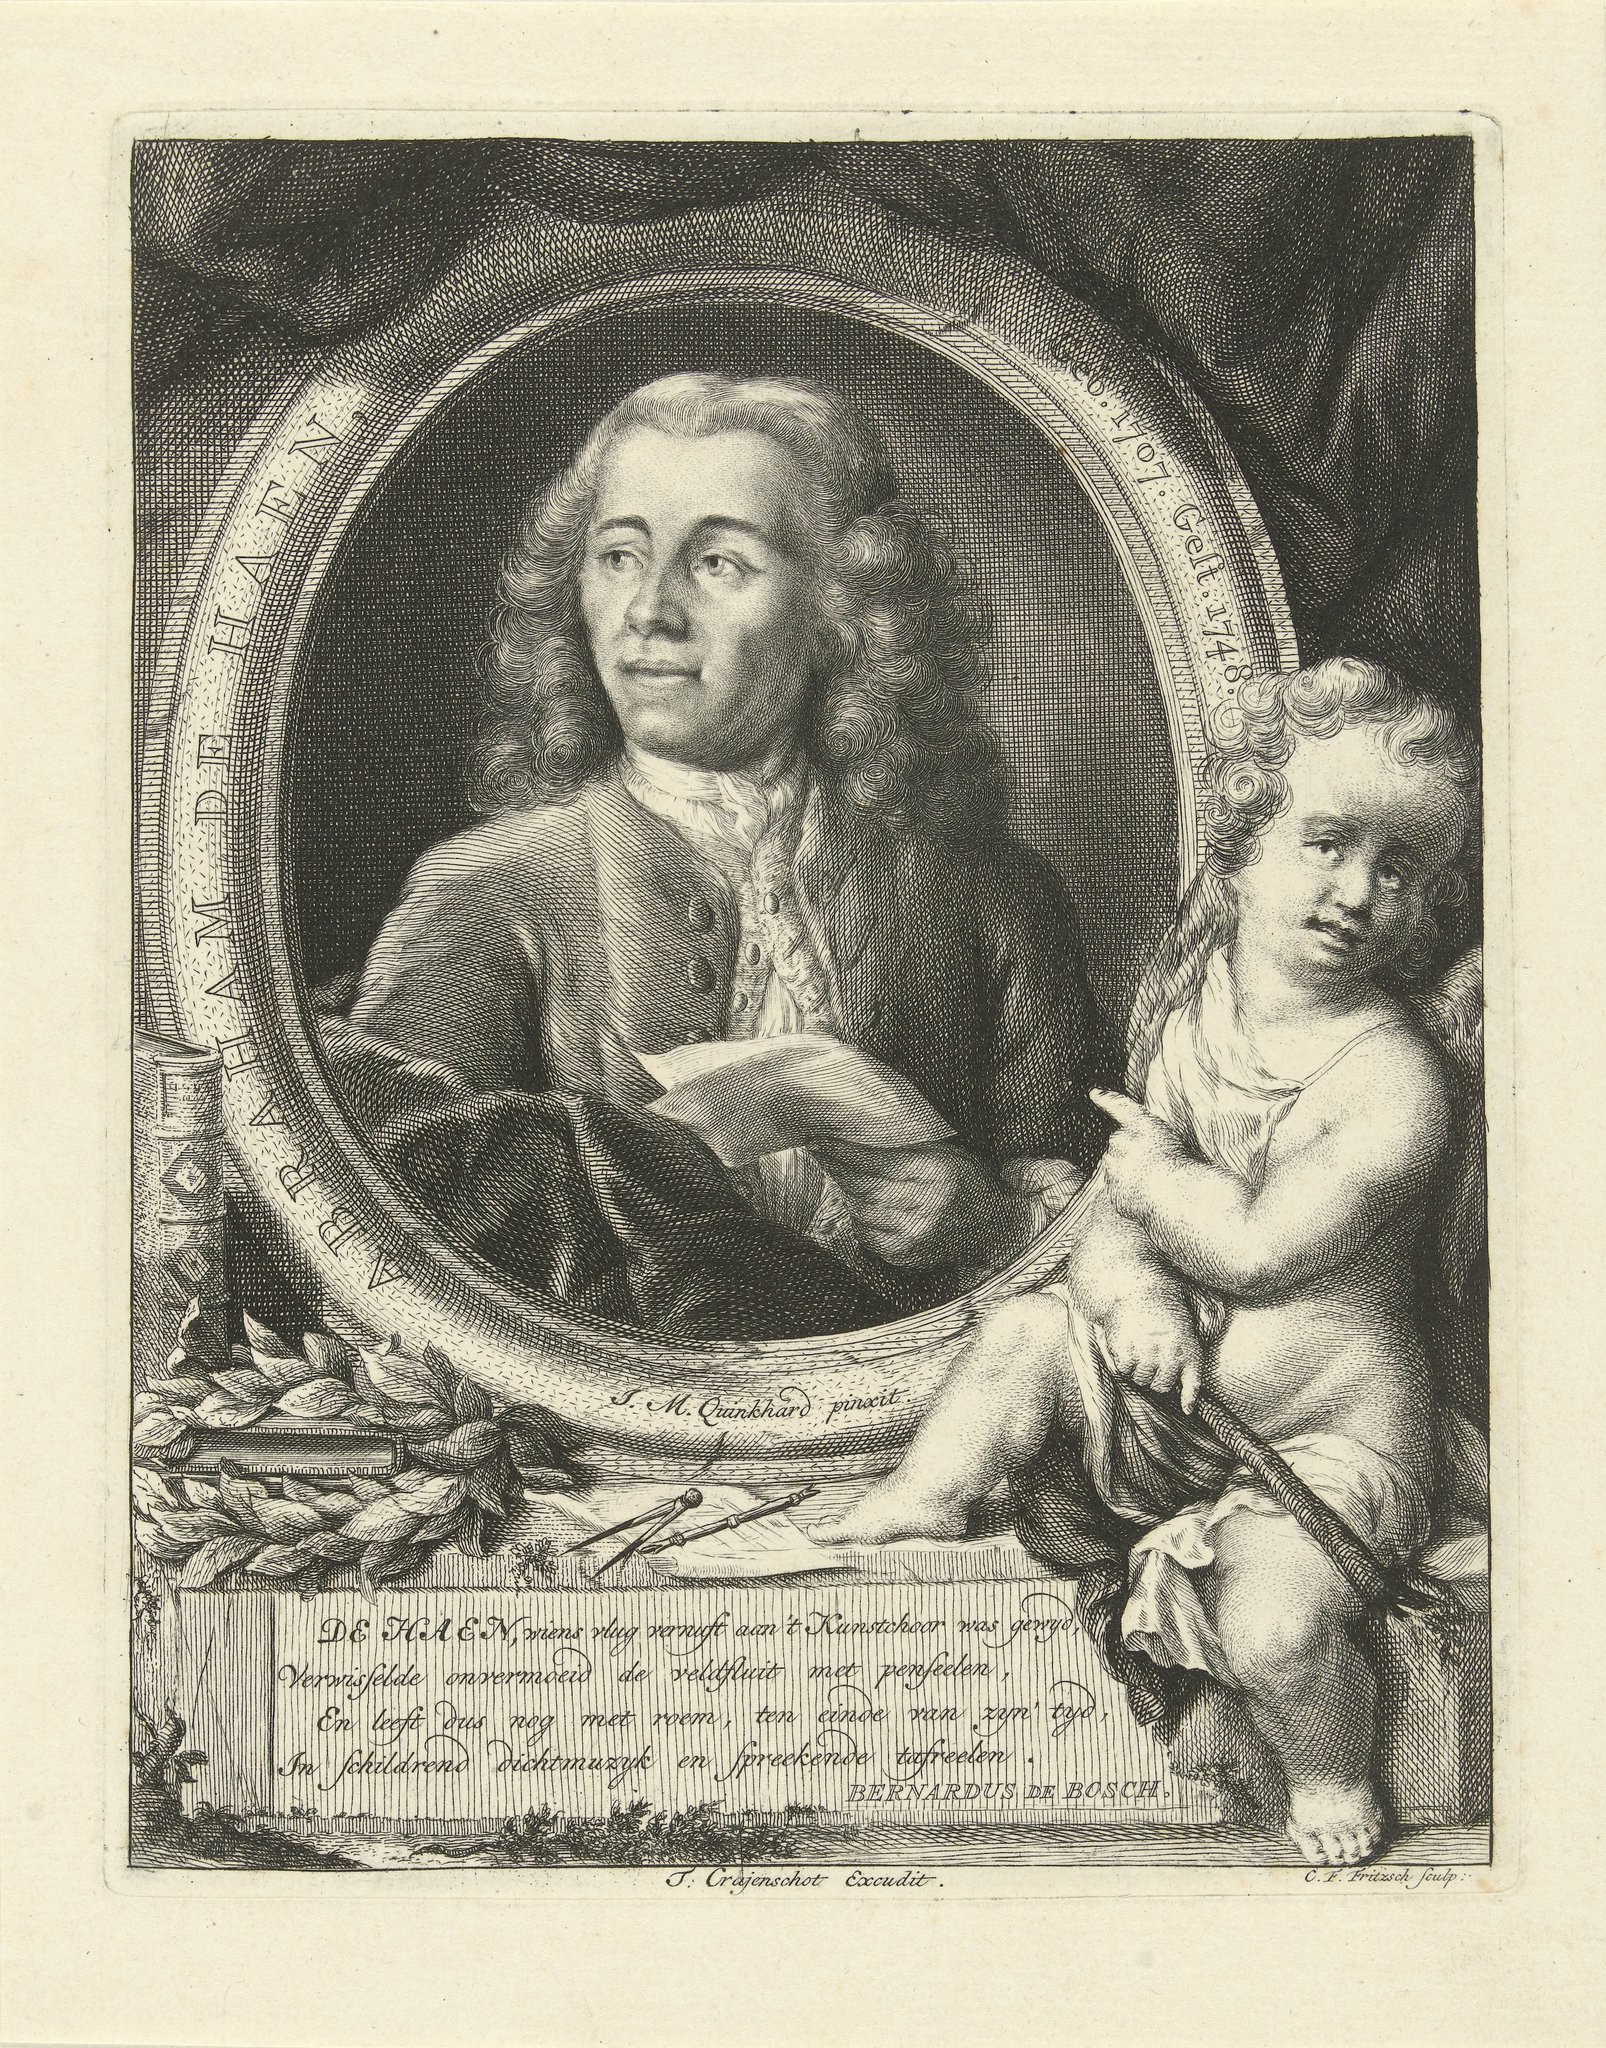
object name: print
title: Portret van Abraham de Haen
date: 1745-1800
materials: paper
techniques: engraving, etching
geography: amsterdam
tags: amsterdam, painter, print maker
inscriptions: collector's mark: Lugt 240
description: Portretbuste van de kunstenaar en dichter Abraham de Haen, een blad papier in de linkerhand. Rechts zit een putto die op het portret wijst; links liggen twee boeken en een lauwerkrans. Midden onder het portret ligt een vel papier met tekengerei. Geheel onderaan staat op een sokkel een vierregelige tekst in het Nederlands.